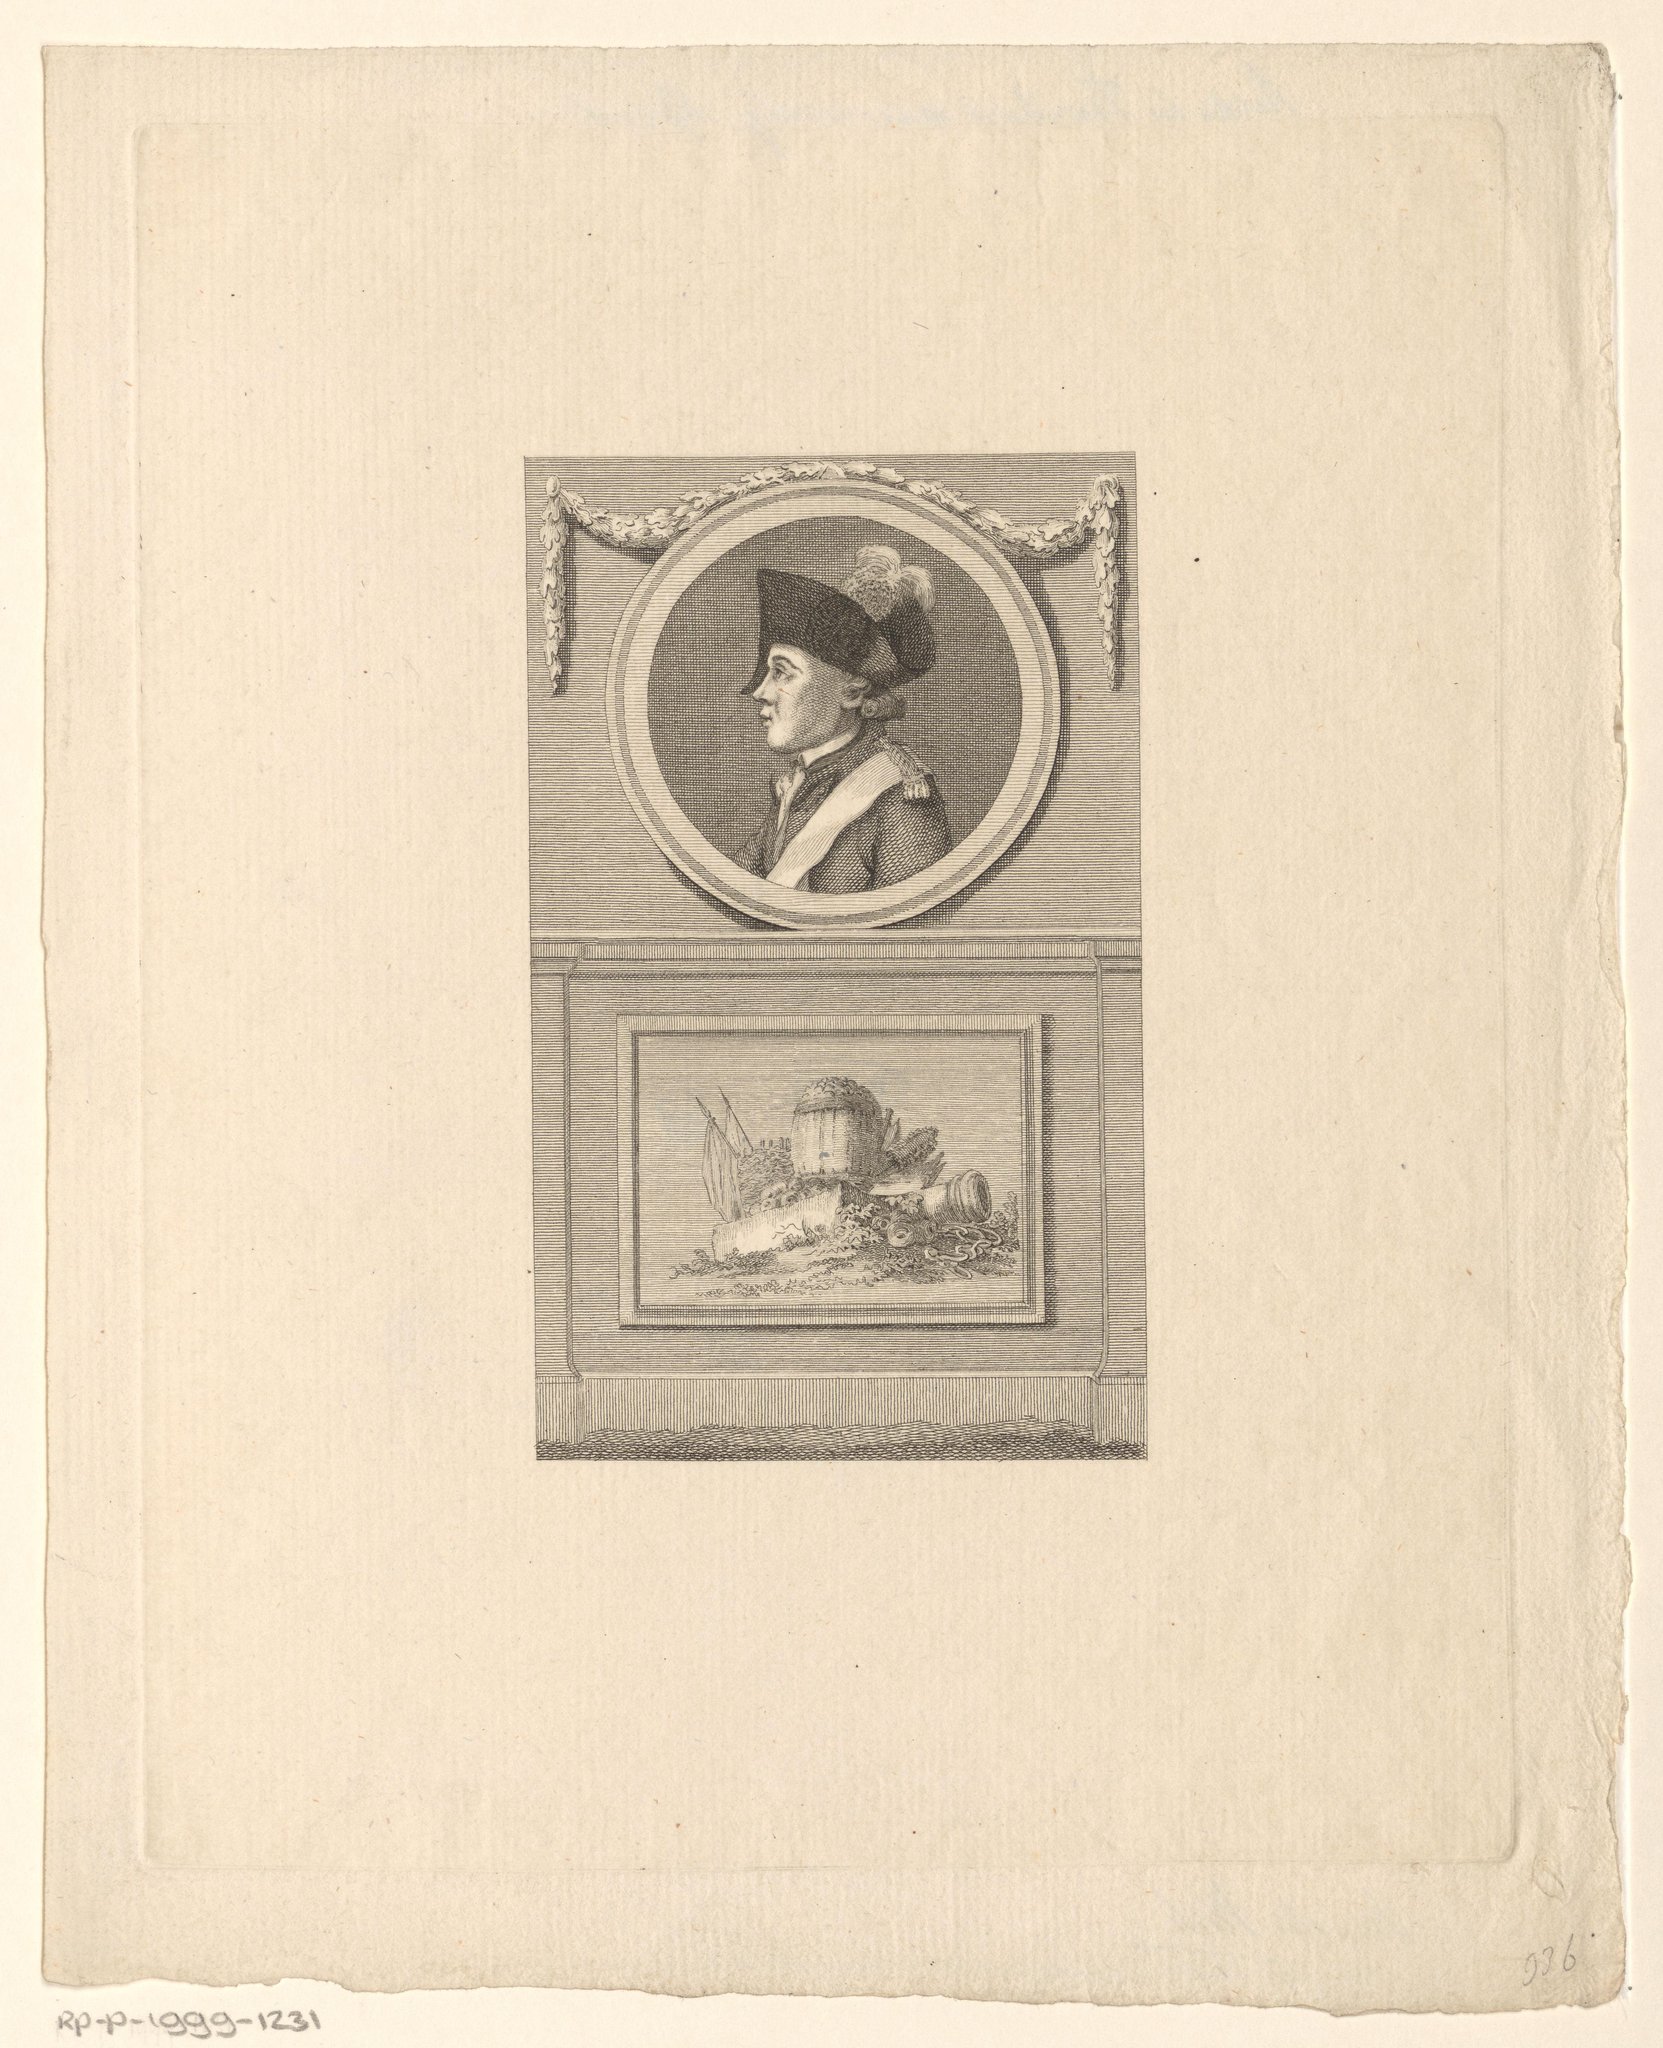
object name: print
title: Portret van Robertus van der Vlerk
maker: Anonymous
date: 1787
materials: paper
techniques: engraving, etching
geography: northern netherlands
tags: utrecht, historical persons, firearms: cannon, officer, patriot (revolutionary)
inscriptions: collector's mark: Lugt 2228, collector's mark: Lugt 2760, number: ‘936’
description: Medaillon met het portret van kanonnier Johannes van der Vlerk, borstbeeld in profiel naar links, boven een trofee met kanon, kruitvat en vaandels. Hij sneuvelde in het gevecht bij Vreeswijk buiten Utrecht tussen gewapende burgers van de Utrechtse schutterij en troepen van het regiment Van Efferen op 9 mei 1787.